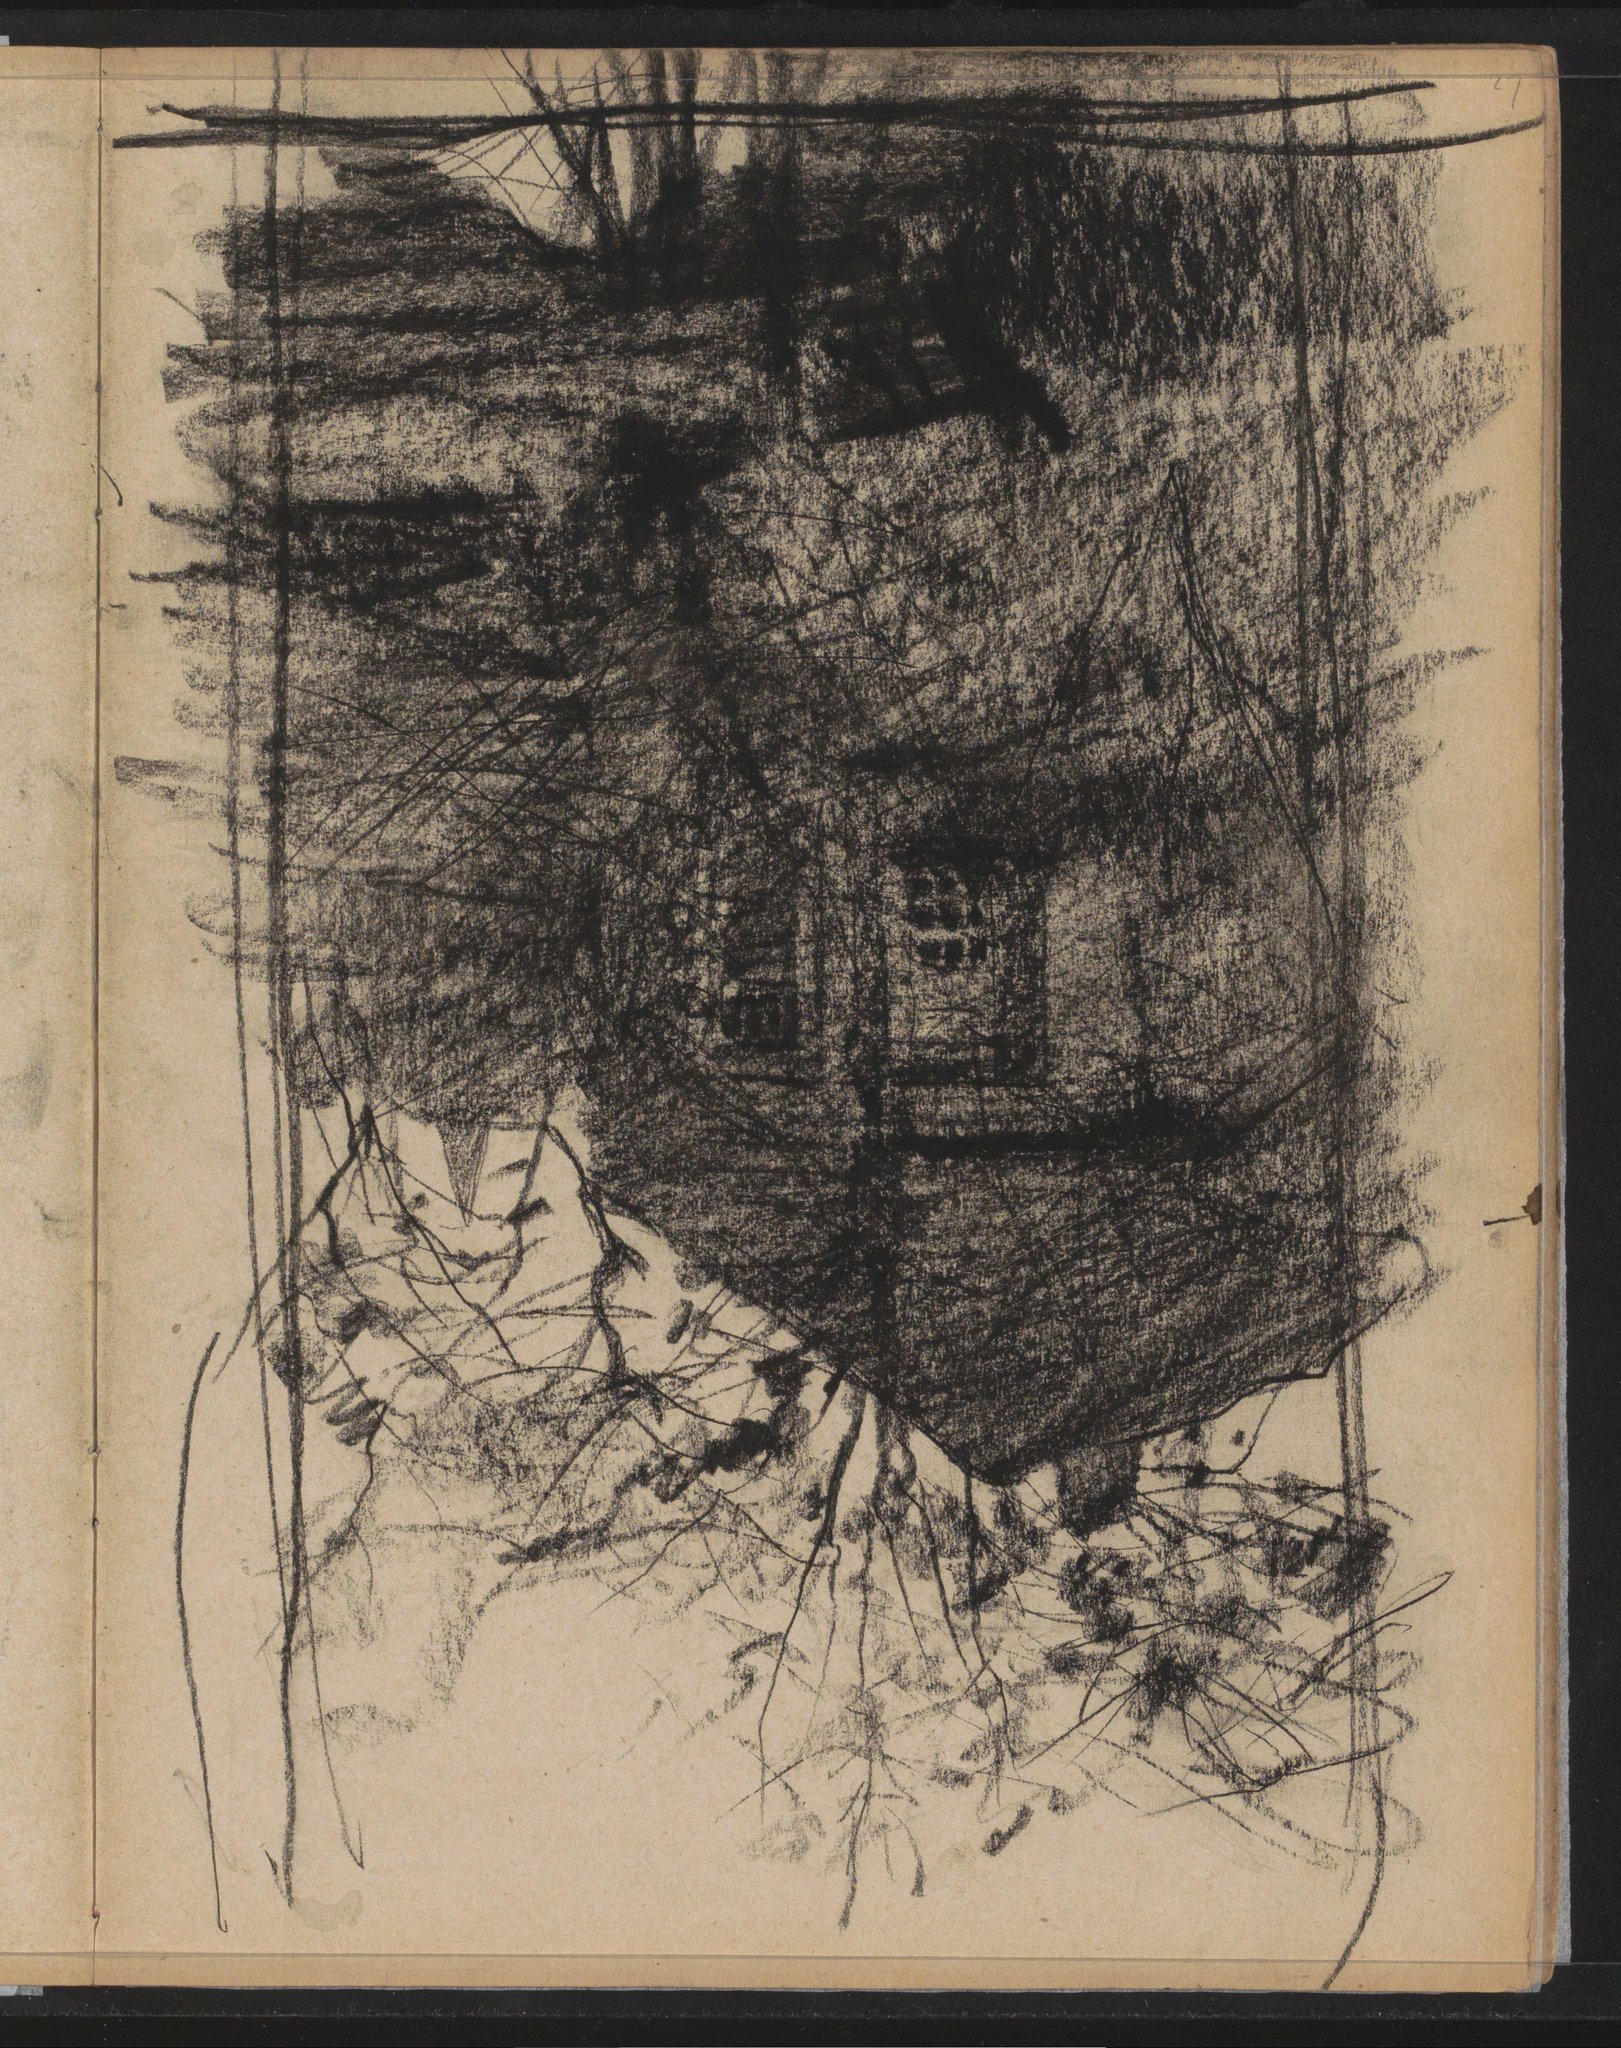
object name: sketchbook leaf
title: Bebouwing, mogelijk te Diepenheim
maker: willem witsen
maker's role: draughtsman, painter, print maker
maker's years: 1860-1923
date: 1887-1888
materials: chalk, paper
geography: diepenheim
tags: rural housing, e.g. country-house, villa, cottage, parts of church exterior and annexes: tower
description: In de verte mogelijk een kerktoren. Pagina 27 uit een schetsboek met 43 bladen.